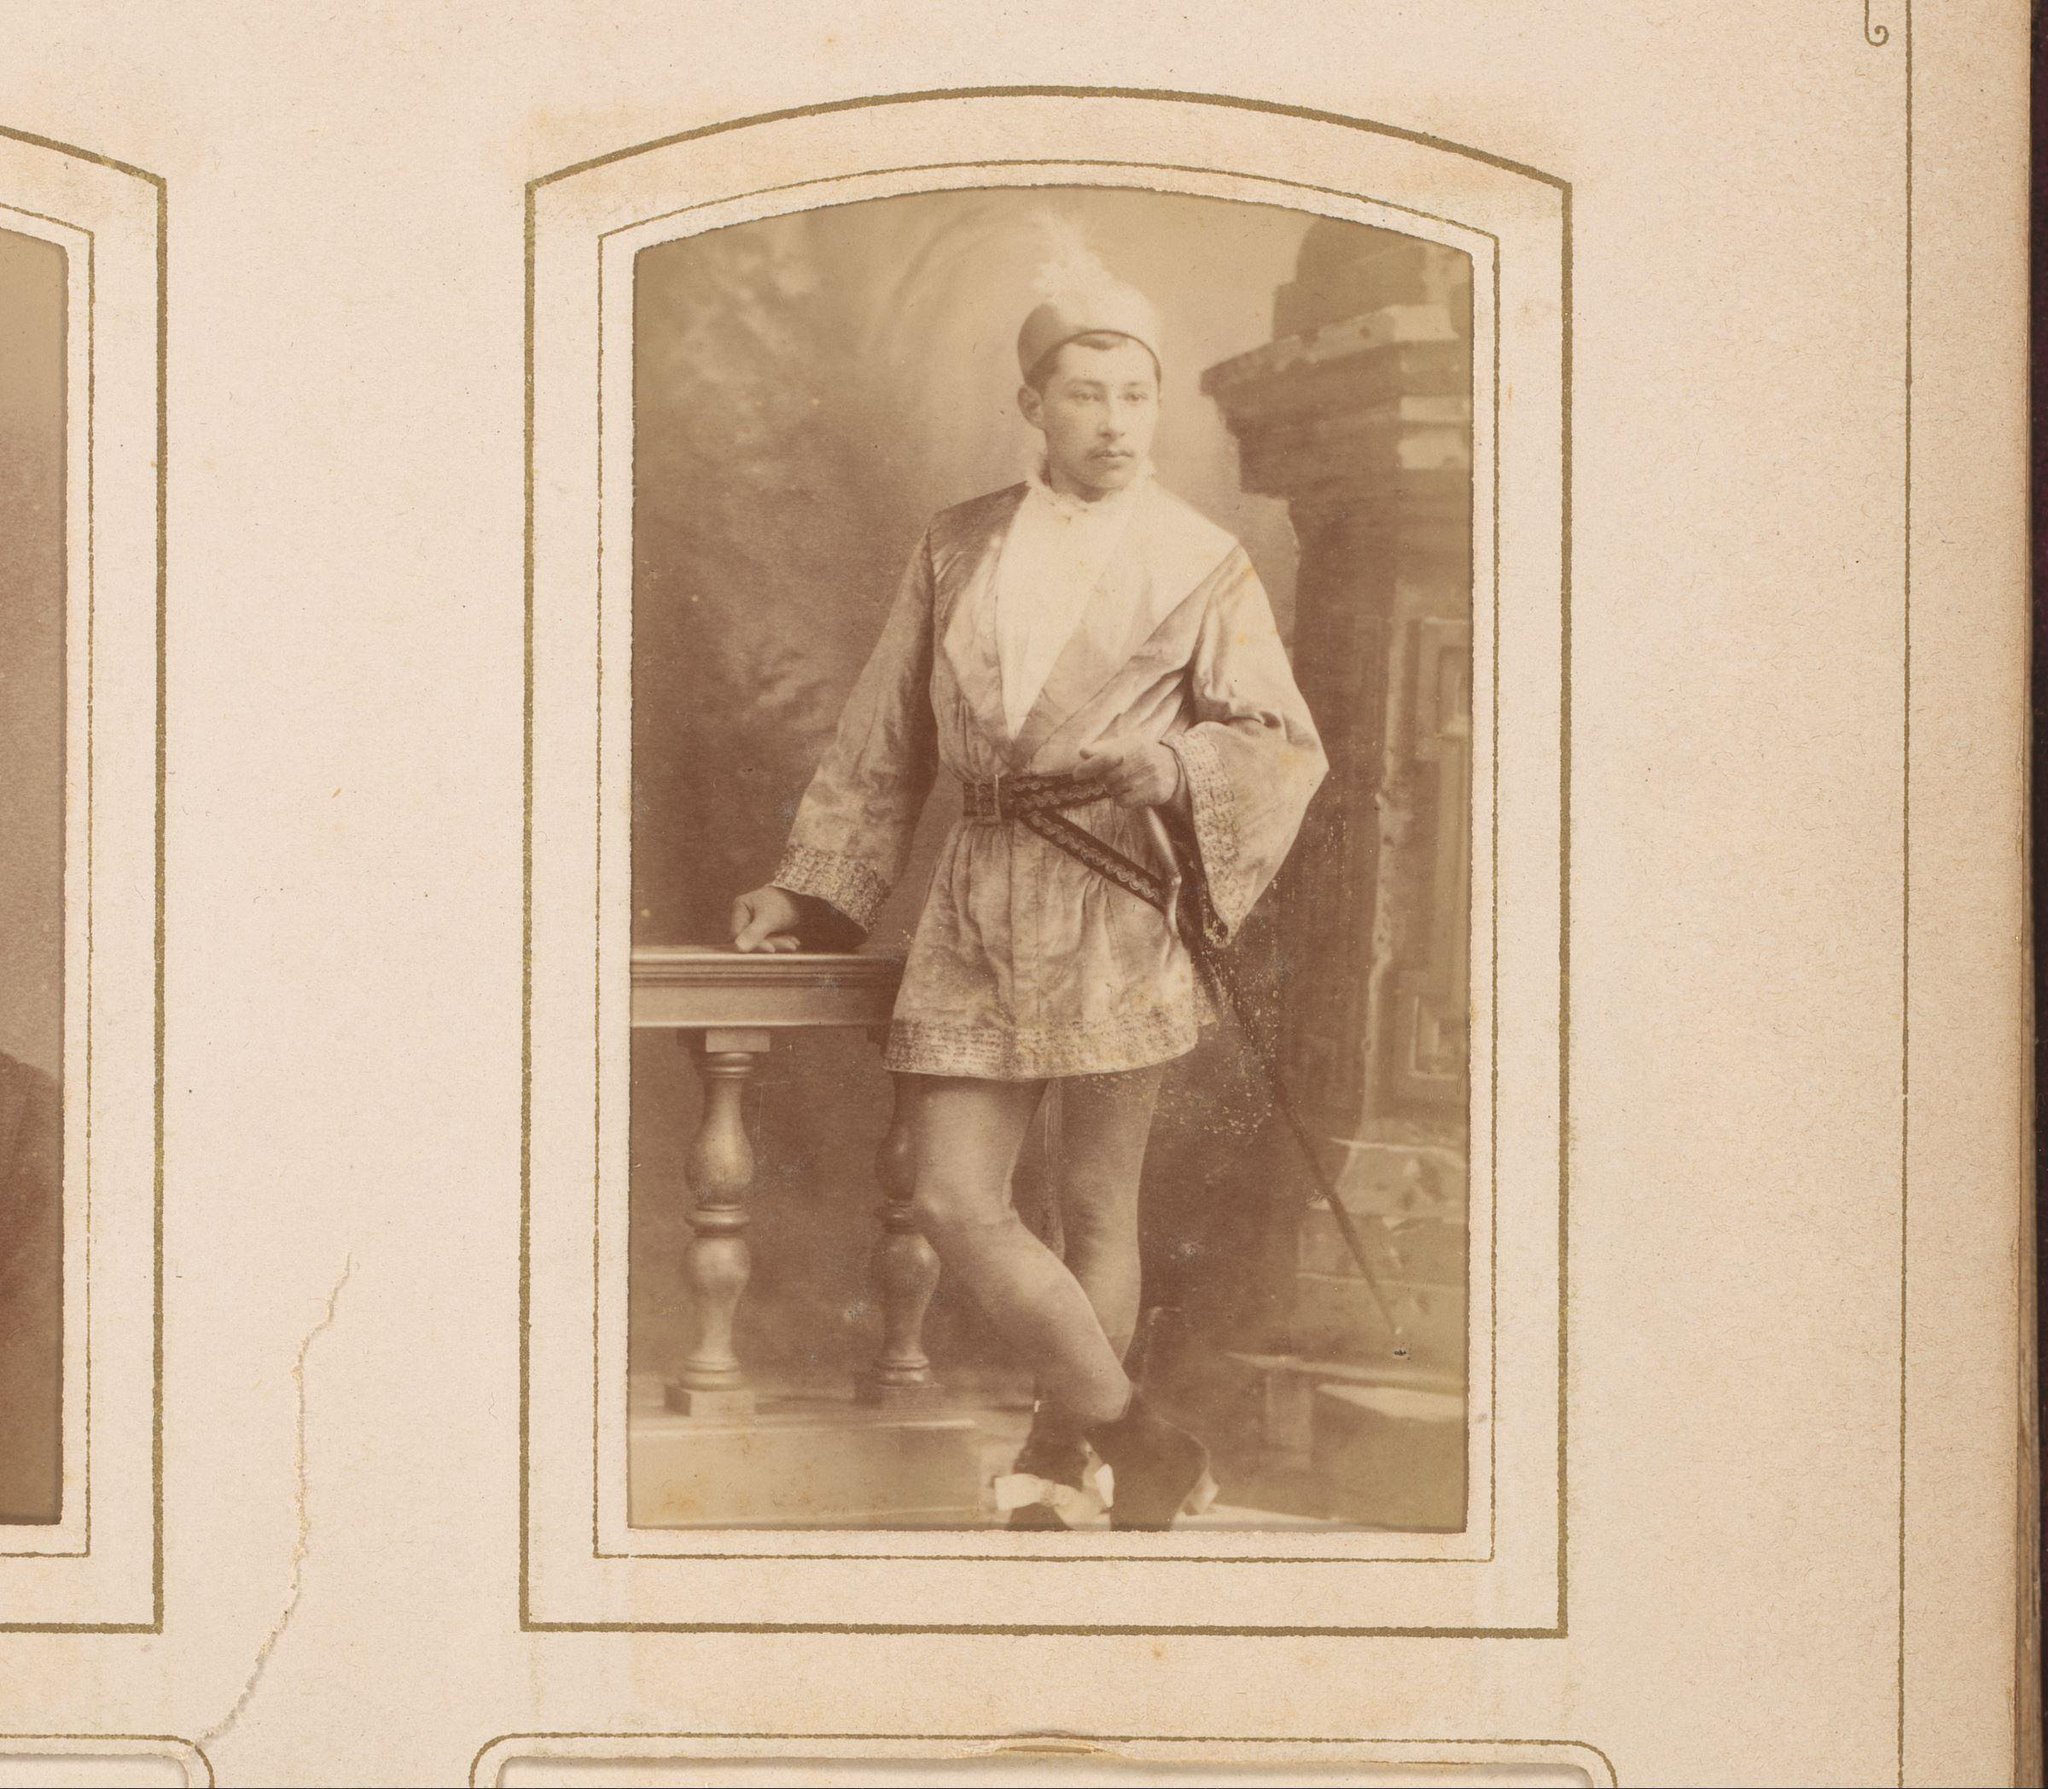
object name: carte de visite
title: Portret van een jongen in kostuum met hoed en zwaard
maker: adolphe zimmermans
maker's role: fotograaf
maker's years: 1858-1922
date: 1885-1900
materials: cardboard, photographic support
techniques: albumen print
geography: the hague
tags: boy (child between toddler and youth), historical persons, hacking and thrusting weapons: sword, head-gear: hat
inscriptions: inscription: ‘ANVERS 1885./ (...)/ Adolphe Zimmermans/ Photographe./ De Riemerstraat No. 21./ La Haye.’